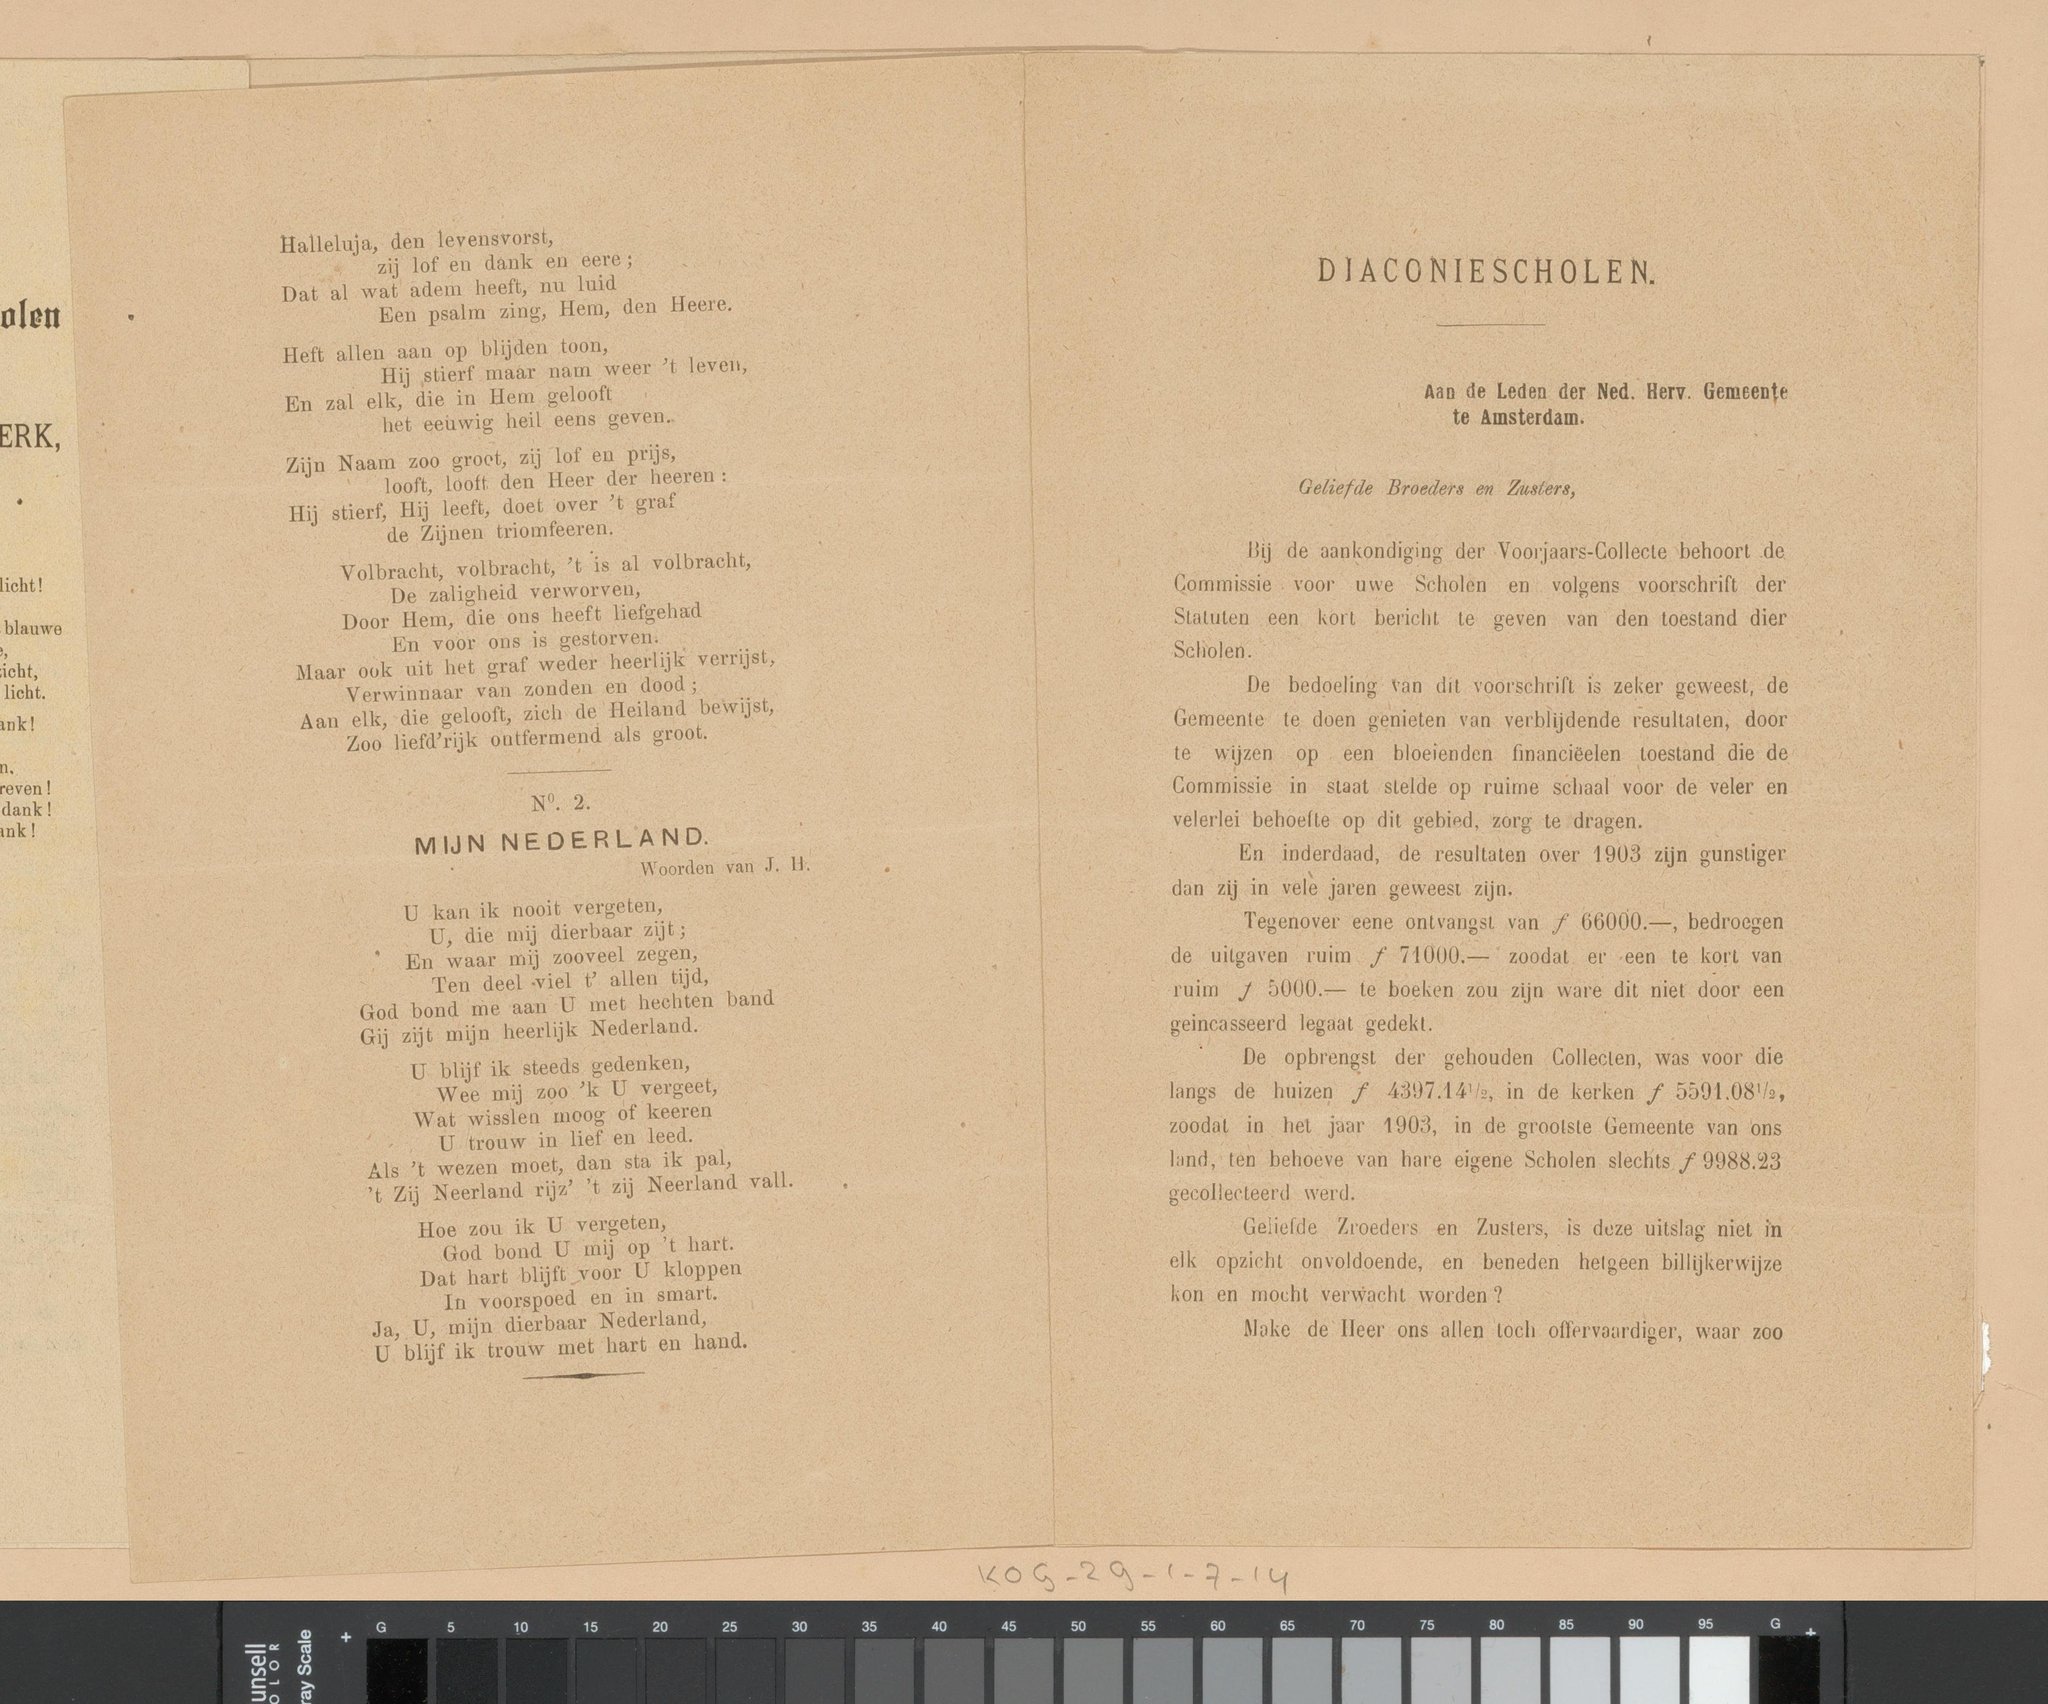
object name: text sheet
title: Liederen te zingen bij het Jaarverslag van de Diaconie-Scholen der Nederd. Herv. Gemeente (...)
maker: Anonymous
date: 1904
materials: paper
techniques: letterpress printing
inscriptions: stamp, collector's mark: Lugt 1641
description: Liedboek voor de presentatie van het jaarverslag van de Diaconie-scholen, 1904. Heb boek bestaat uit vier gevouwen pagina's en is op alle zijde bedrukt. Op de eerste twee pagina's zijn diverse liedtekst gedrukt en op de laatste twee bladen staan een aankondiging van de komende collecte. Onderwerpsrubrieken binnen de Atlas Zeden en Gewoonten: Godsdienst, Ned. Hervormden, (Oudtijds Gereformeerden).